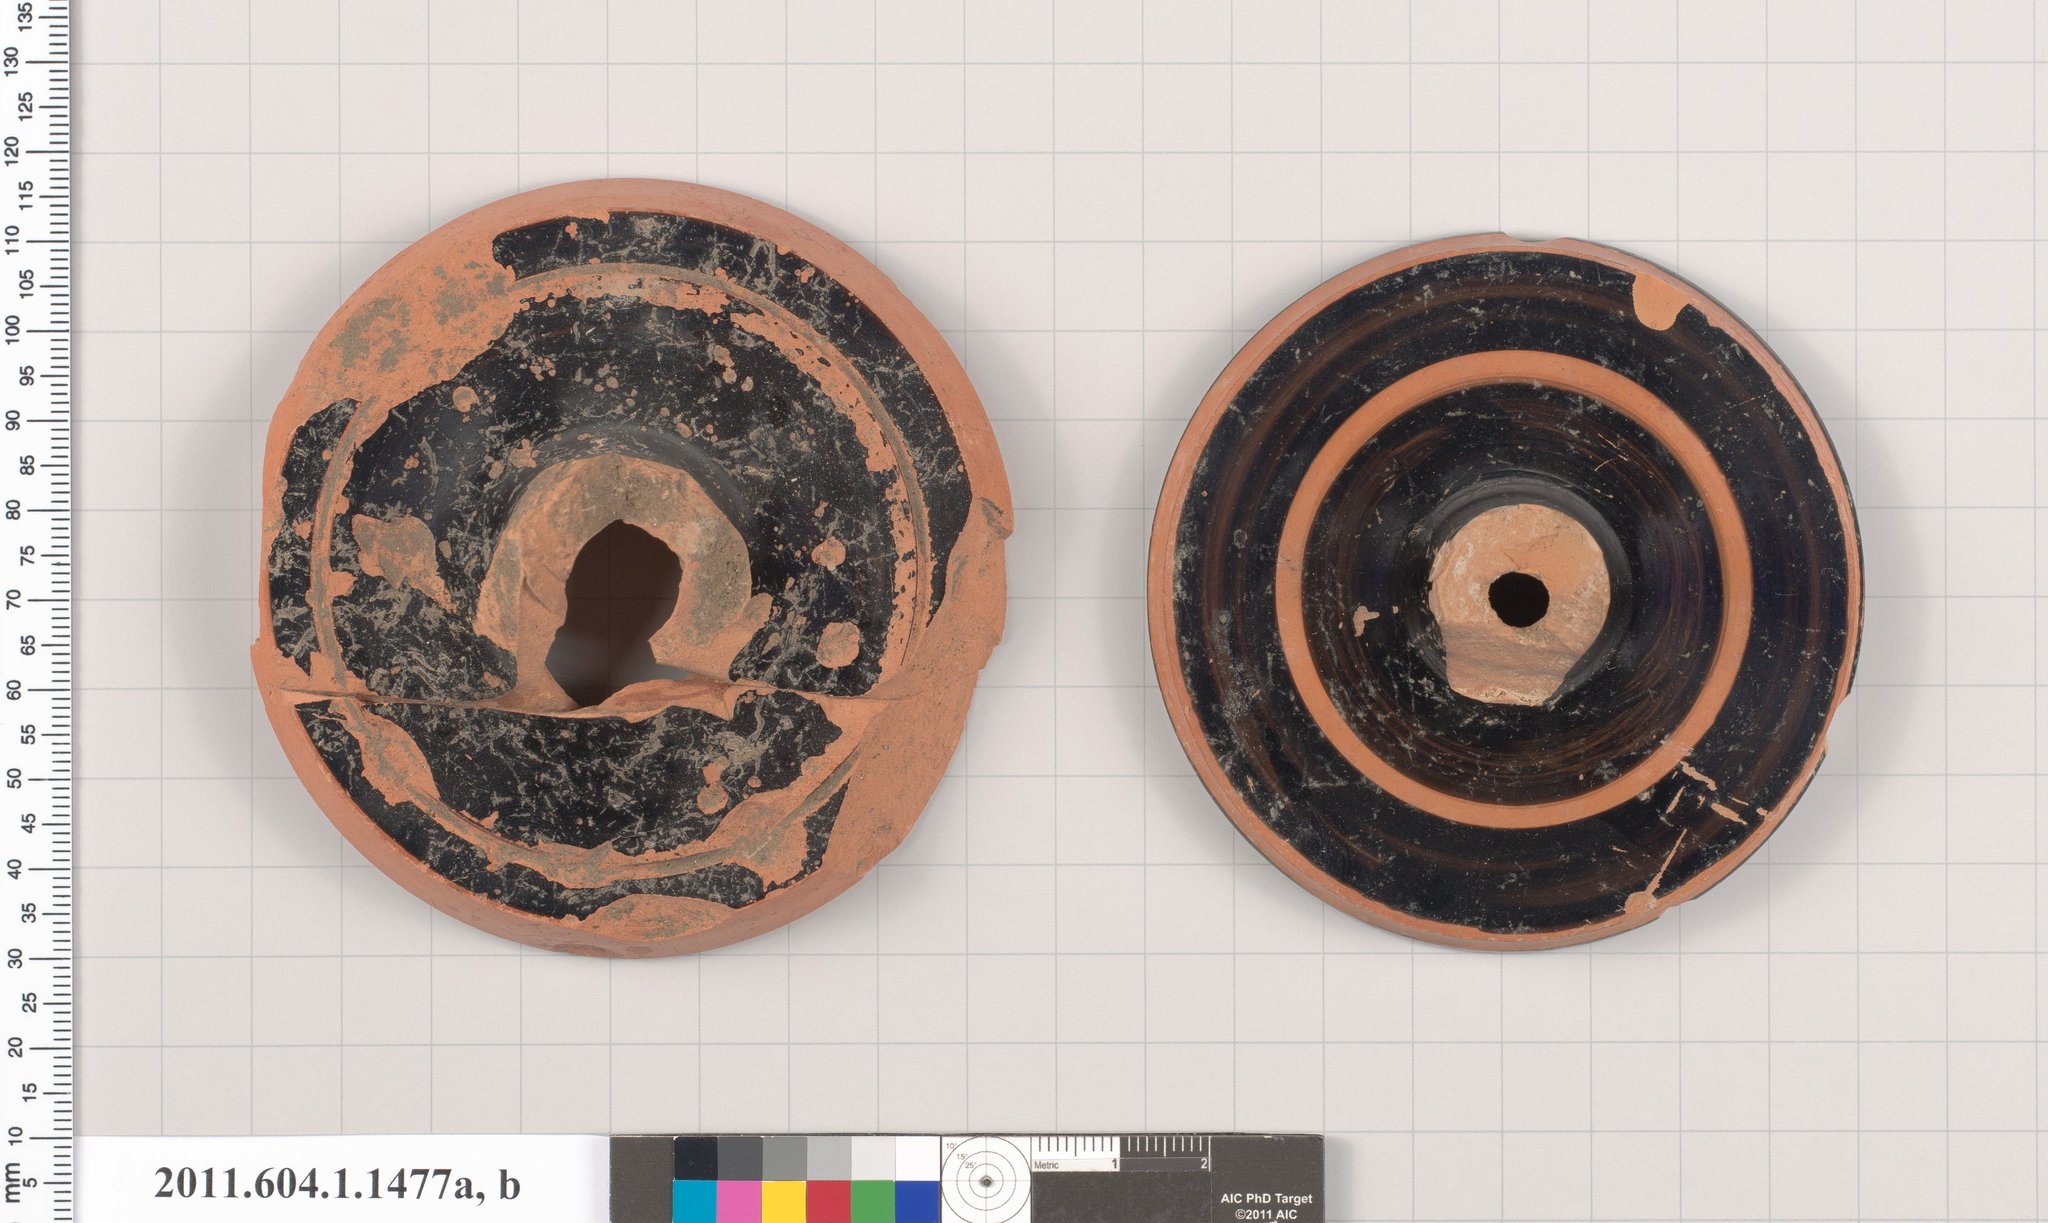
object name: kylix fragment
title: Terracotta fragments of kylikes (drinking cups)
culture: greek, attic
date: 500-401 BCE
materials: terracotta